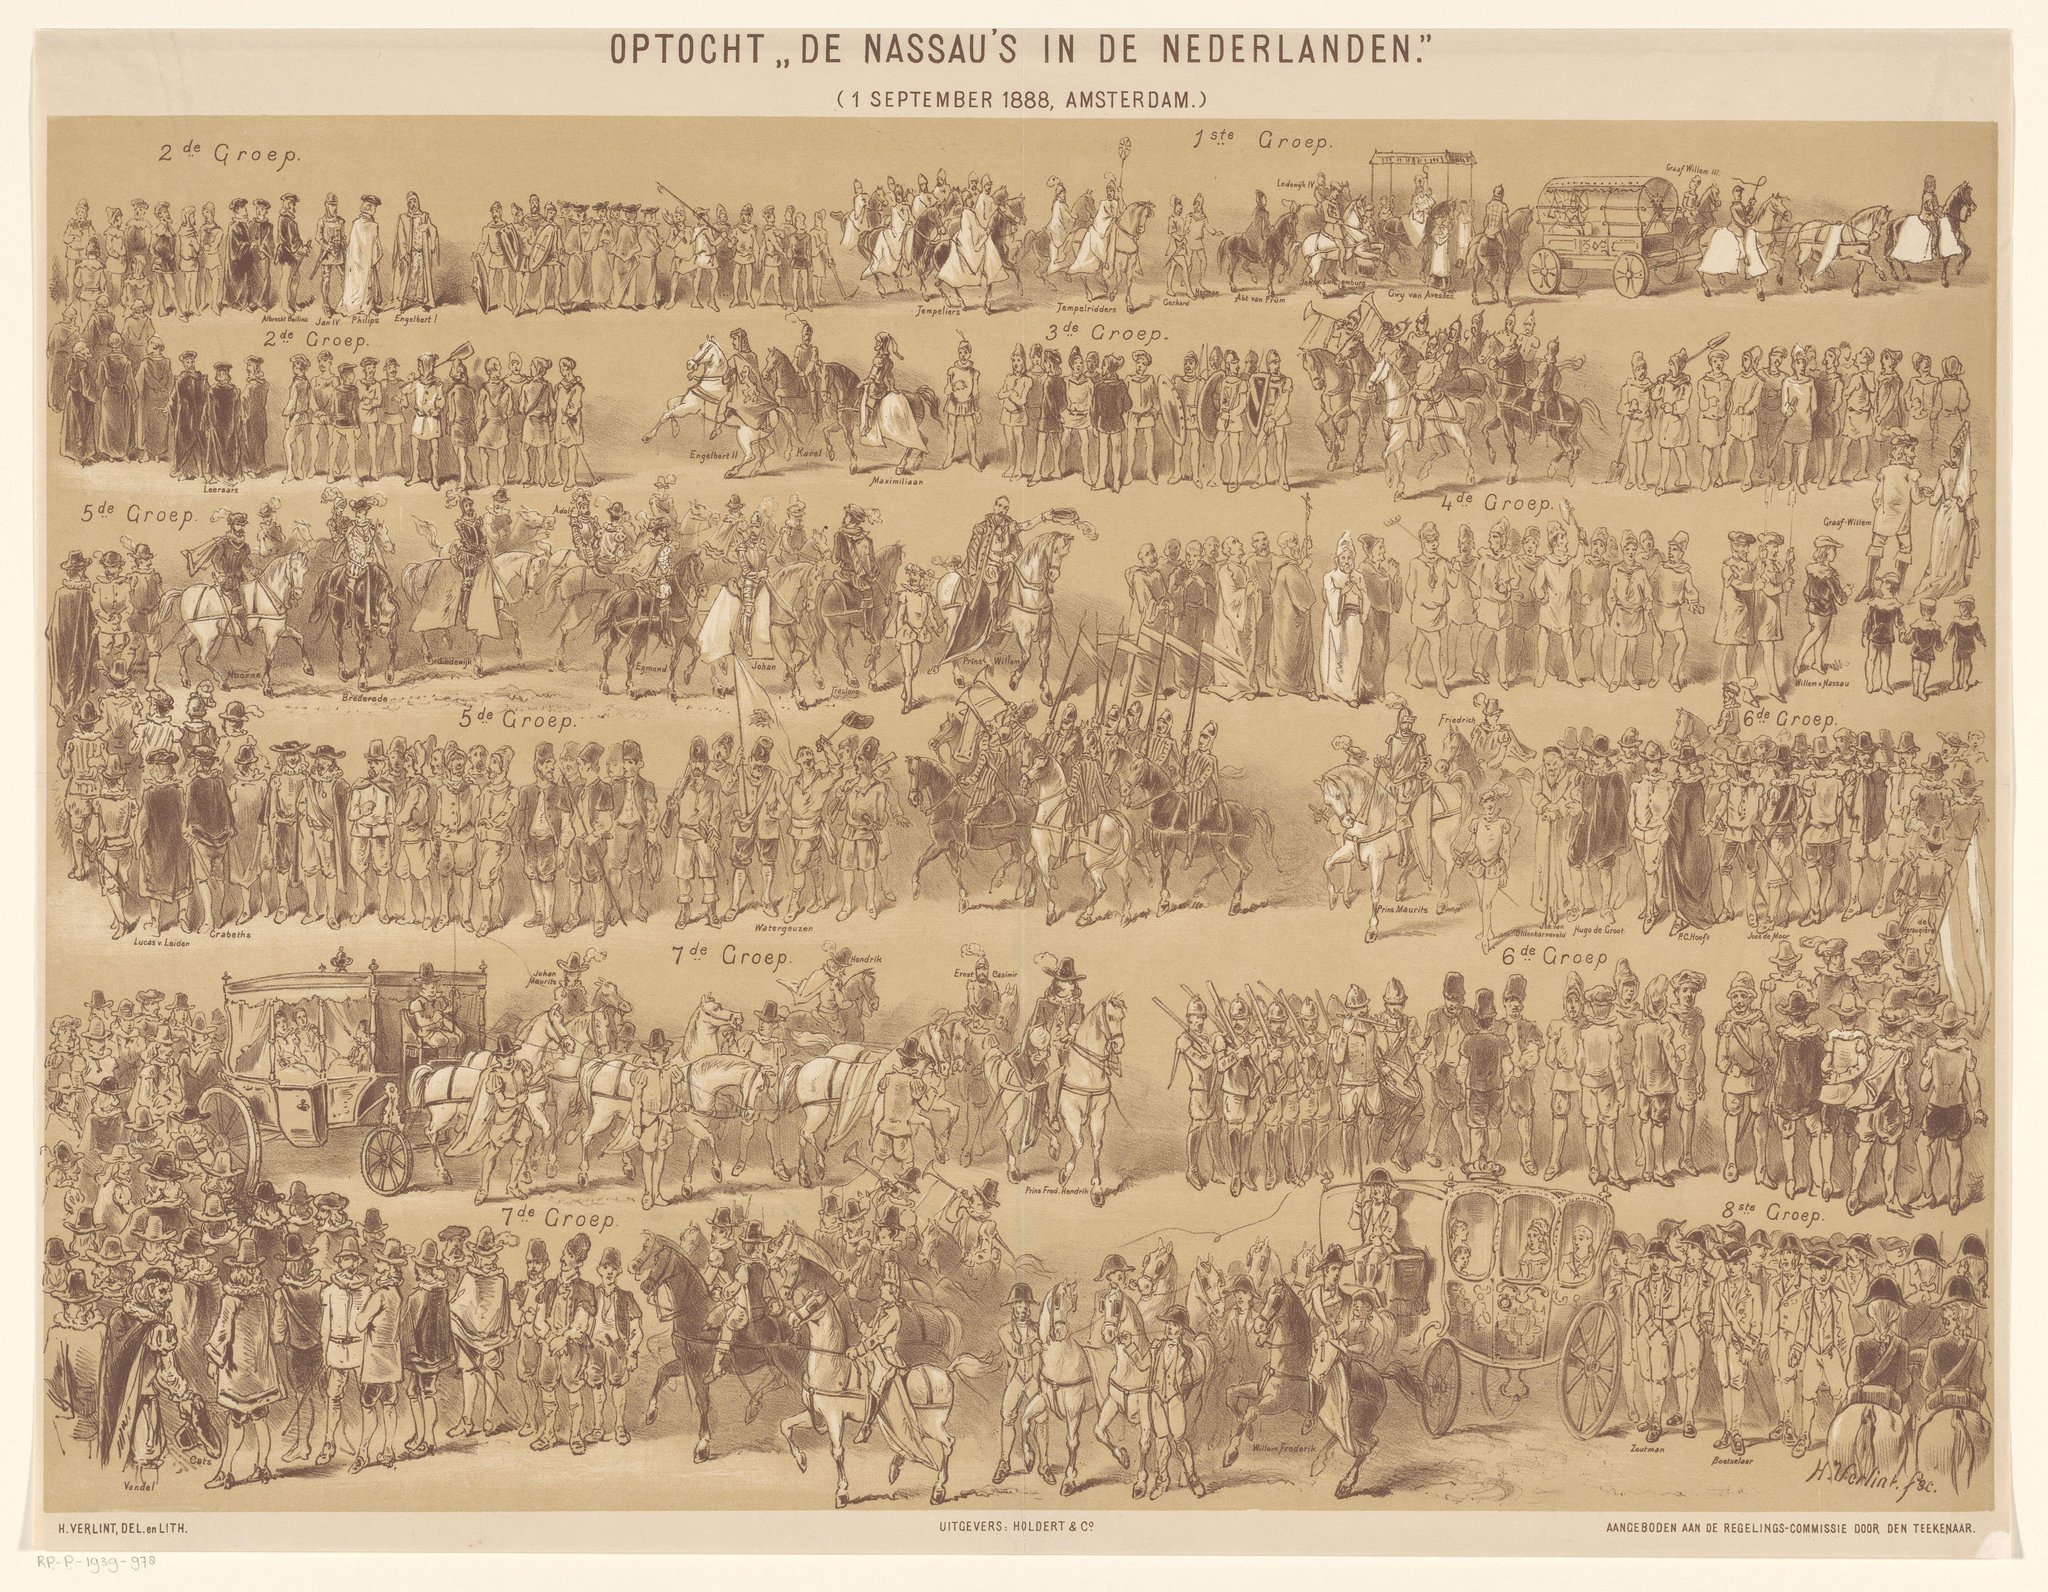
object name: print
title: Historische optocht te Amsterdam naar aanleiding van Prinsessedag, 1888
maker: hendrik verlint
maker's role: print maker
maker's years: 1846-1918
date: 1888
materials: paper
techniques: tone lithography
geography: amsterdam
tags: the hague, print maker, wilhelmina of the netherlands, costumes used in pageants, public festivities on the occasion of royal events (+ parade, pageant, cavalcade ~ festive activities), amsterdam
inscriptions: collector's mark: Lugt 2228, collector's mark: Lugt 2760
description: Het Prinsessefeest: de historische optocht voorstellende het geslacht Oranje-Nassau in de Nederlanden, gehouden op 1 september 1888 te Amsterdam ter gelegenheid van de verjaardag van Prinses Wilhelmina. De stoet afgebeeld in zes rijen onder elkaar, met afzonderlijke groepen genummerd 1ste - 8ste Groep.